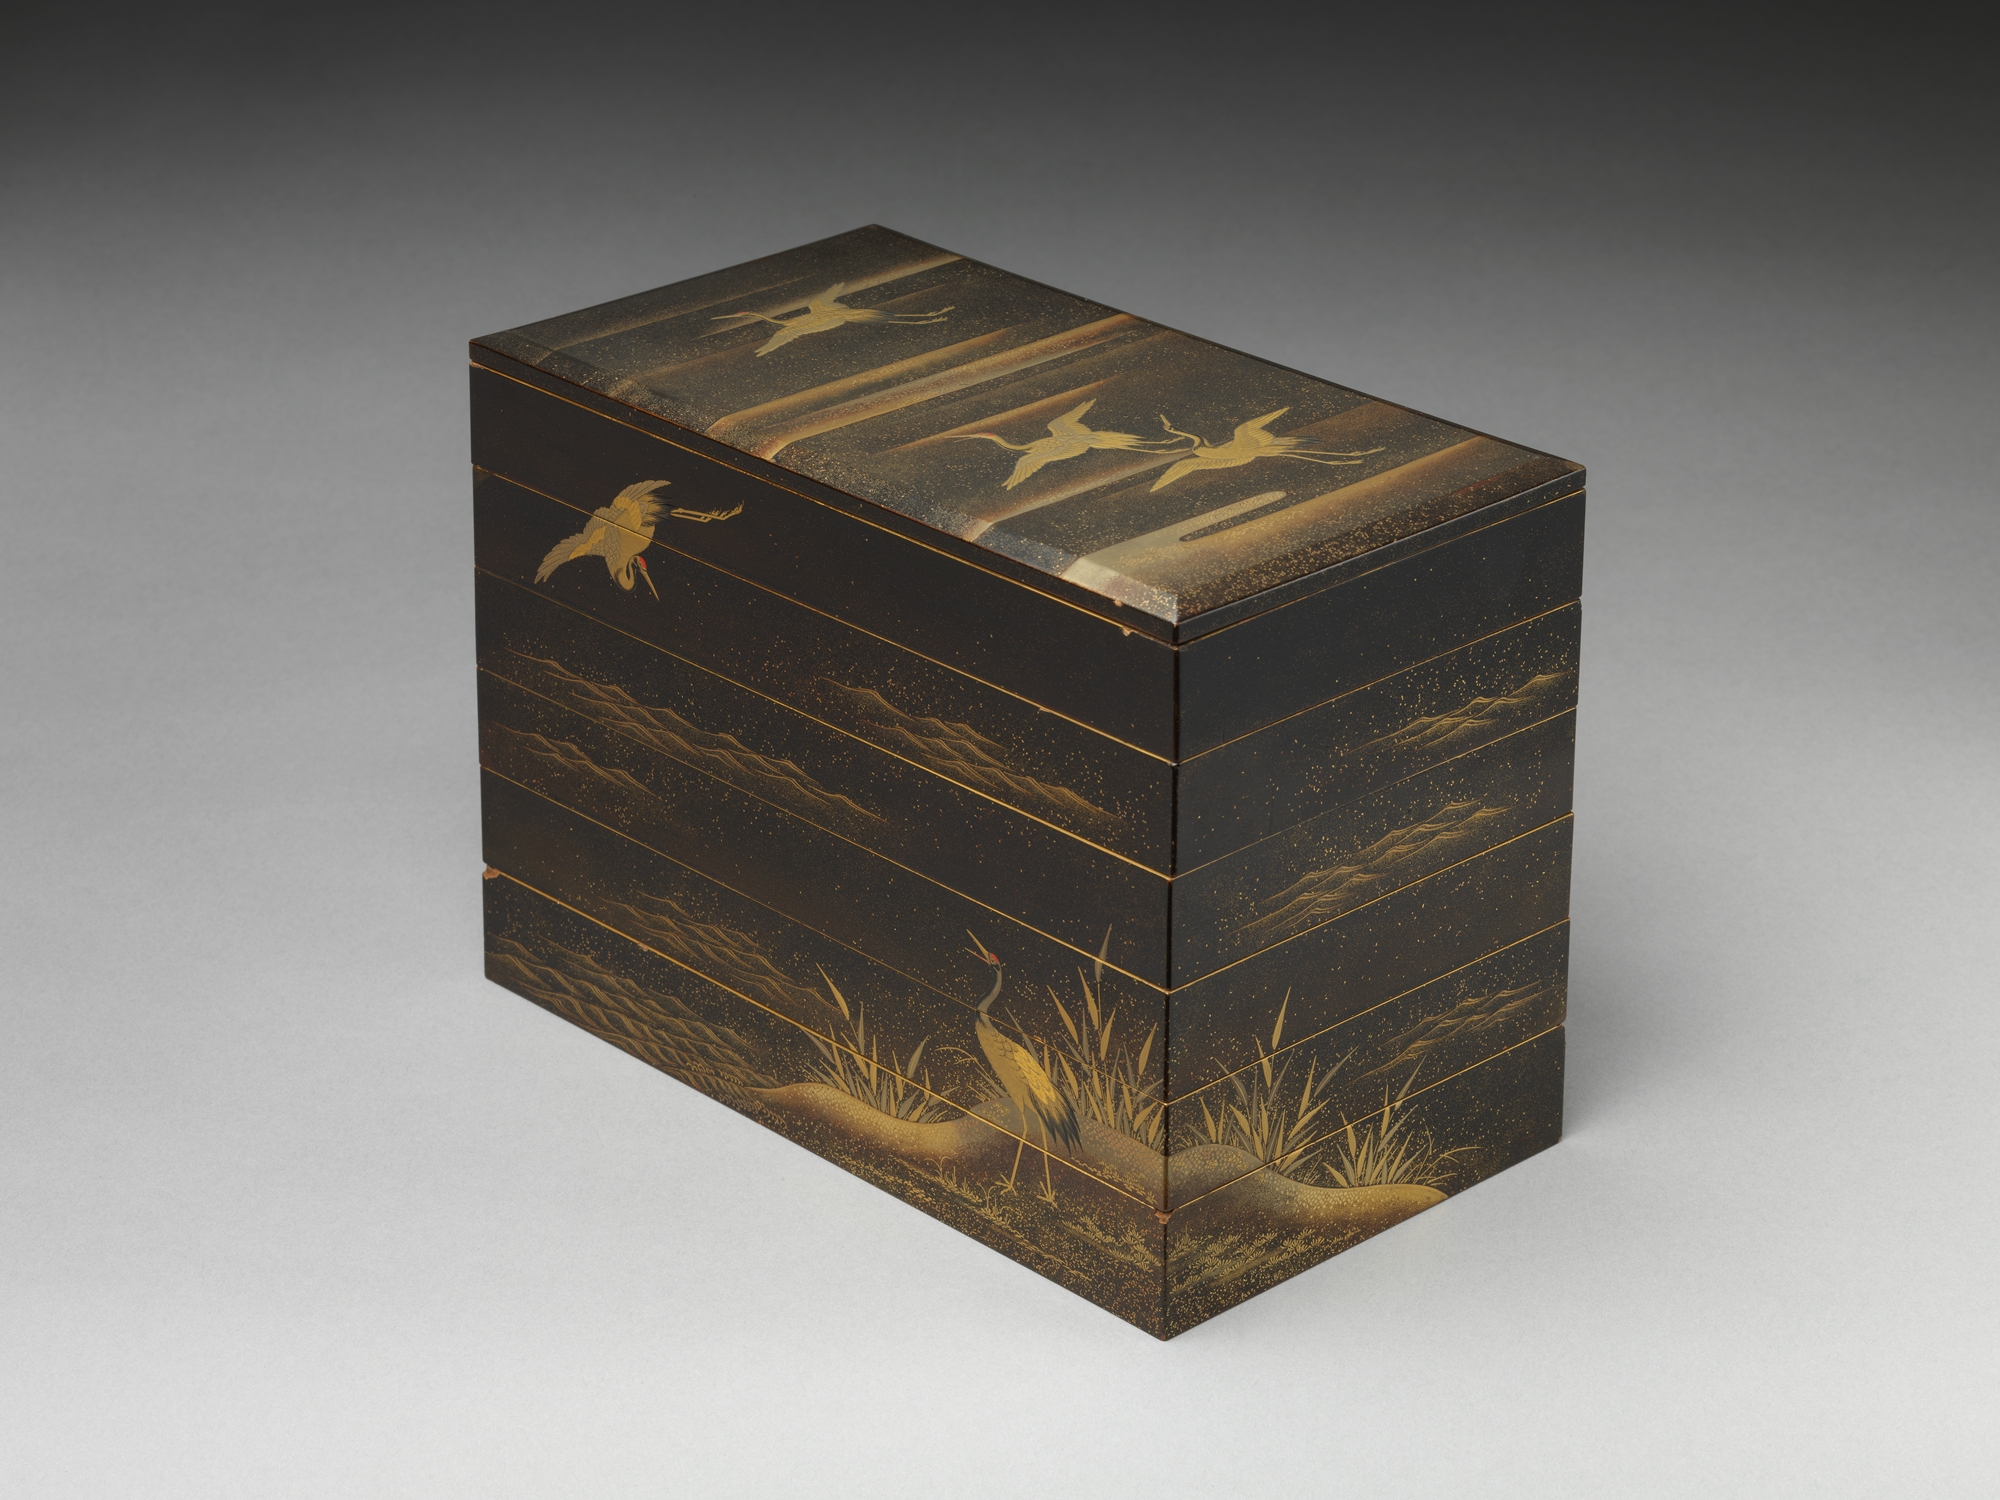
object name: tiered box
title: Tiered Box with Reeds and Crane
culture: japanese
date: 1701-1800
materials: gold, lacquer, silver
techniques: hiramakie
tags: cranes